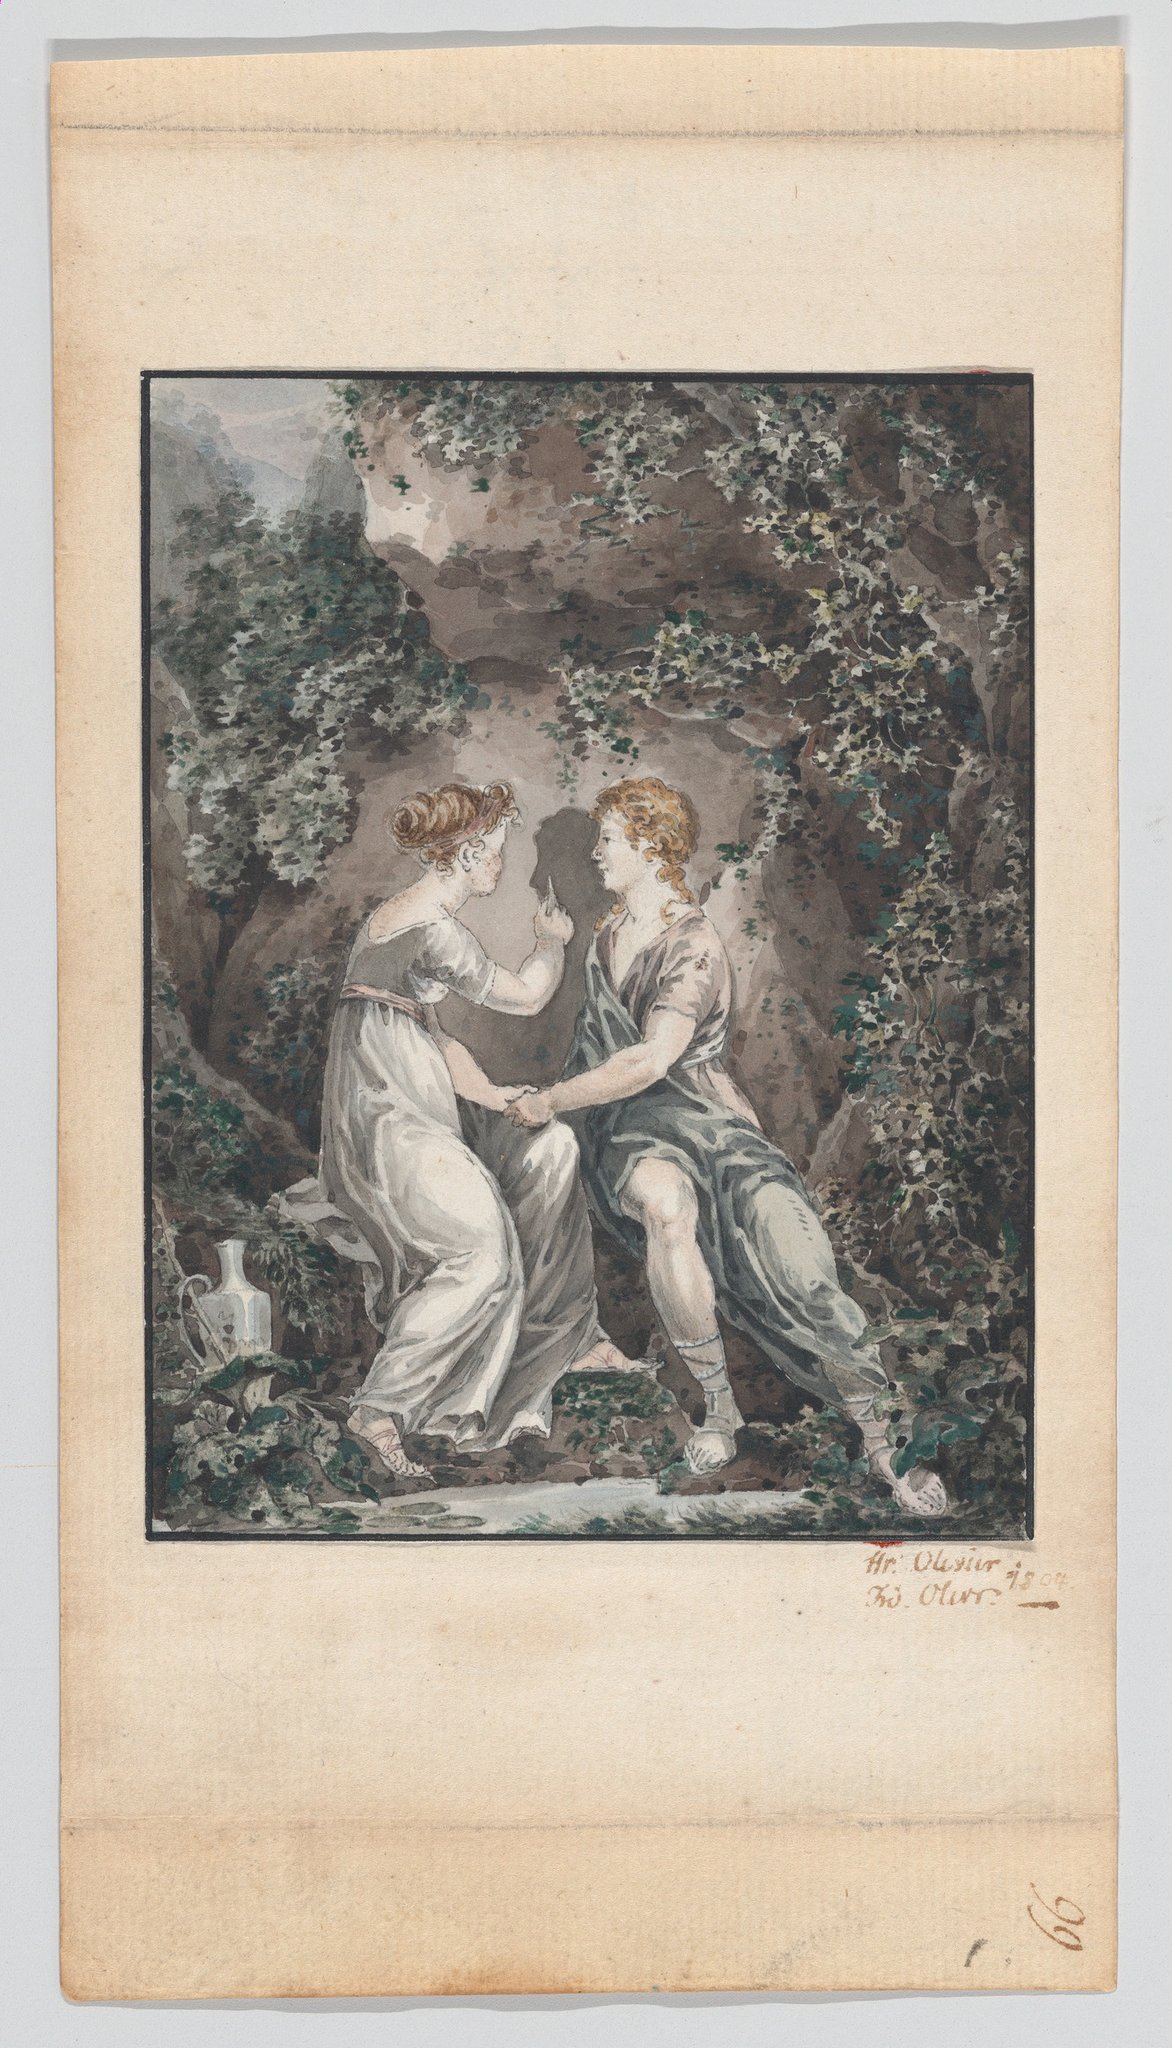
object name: drawing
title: The Invention of the Art of Drawing (the daughter of Butades of Sicyon and her Lover)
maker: (johann heinrich) ferdinand olivier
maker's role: artist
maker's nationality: german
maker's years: 1785-1841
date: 1804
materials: ink, watercolor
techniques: pen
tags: painting,men,lovers,women